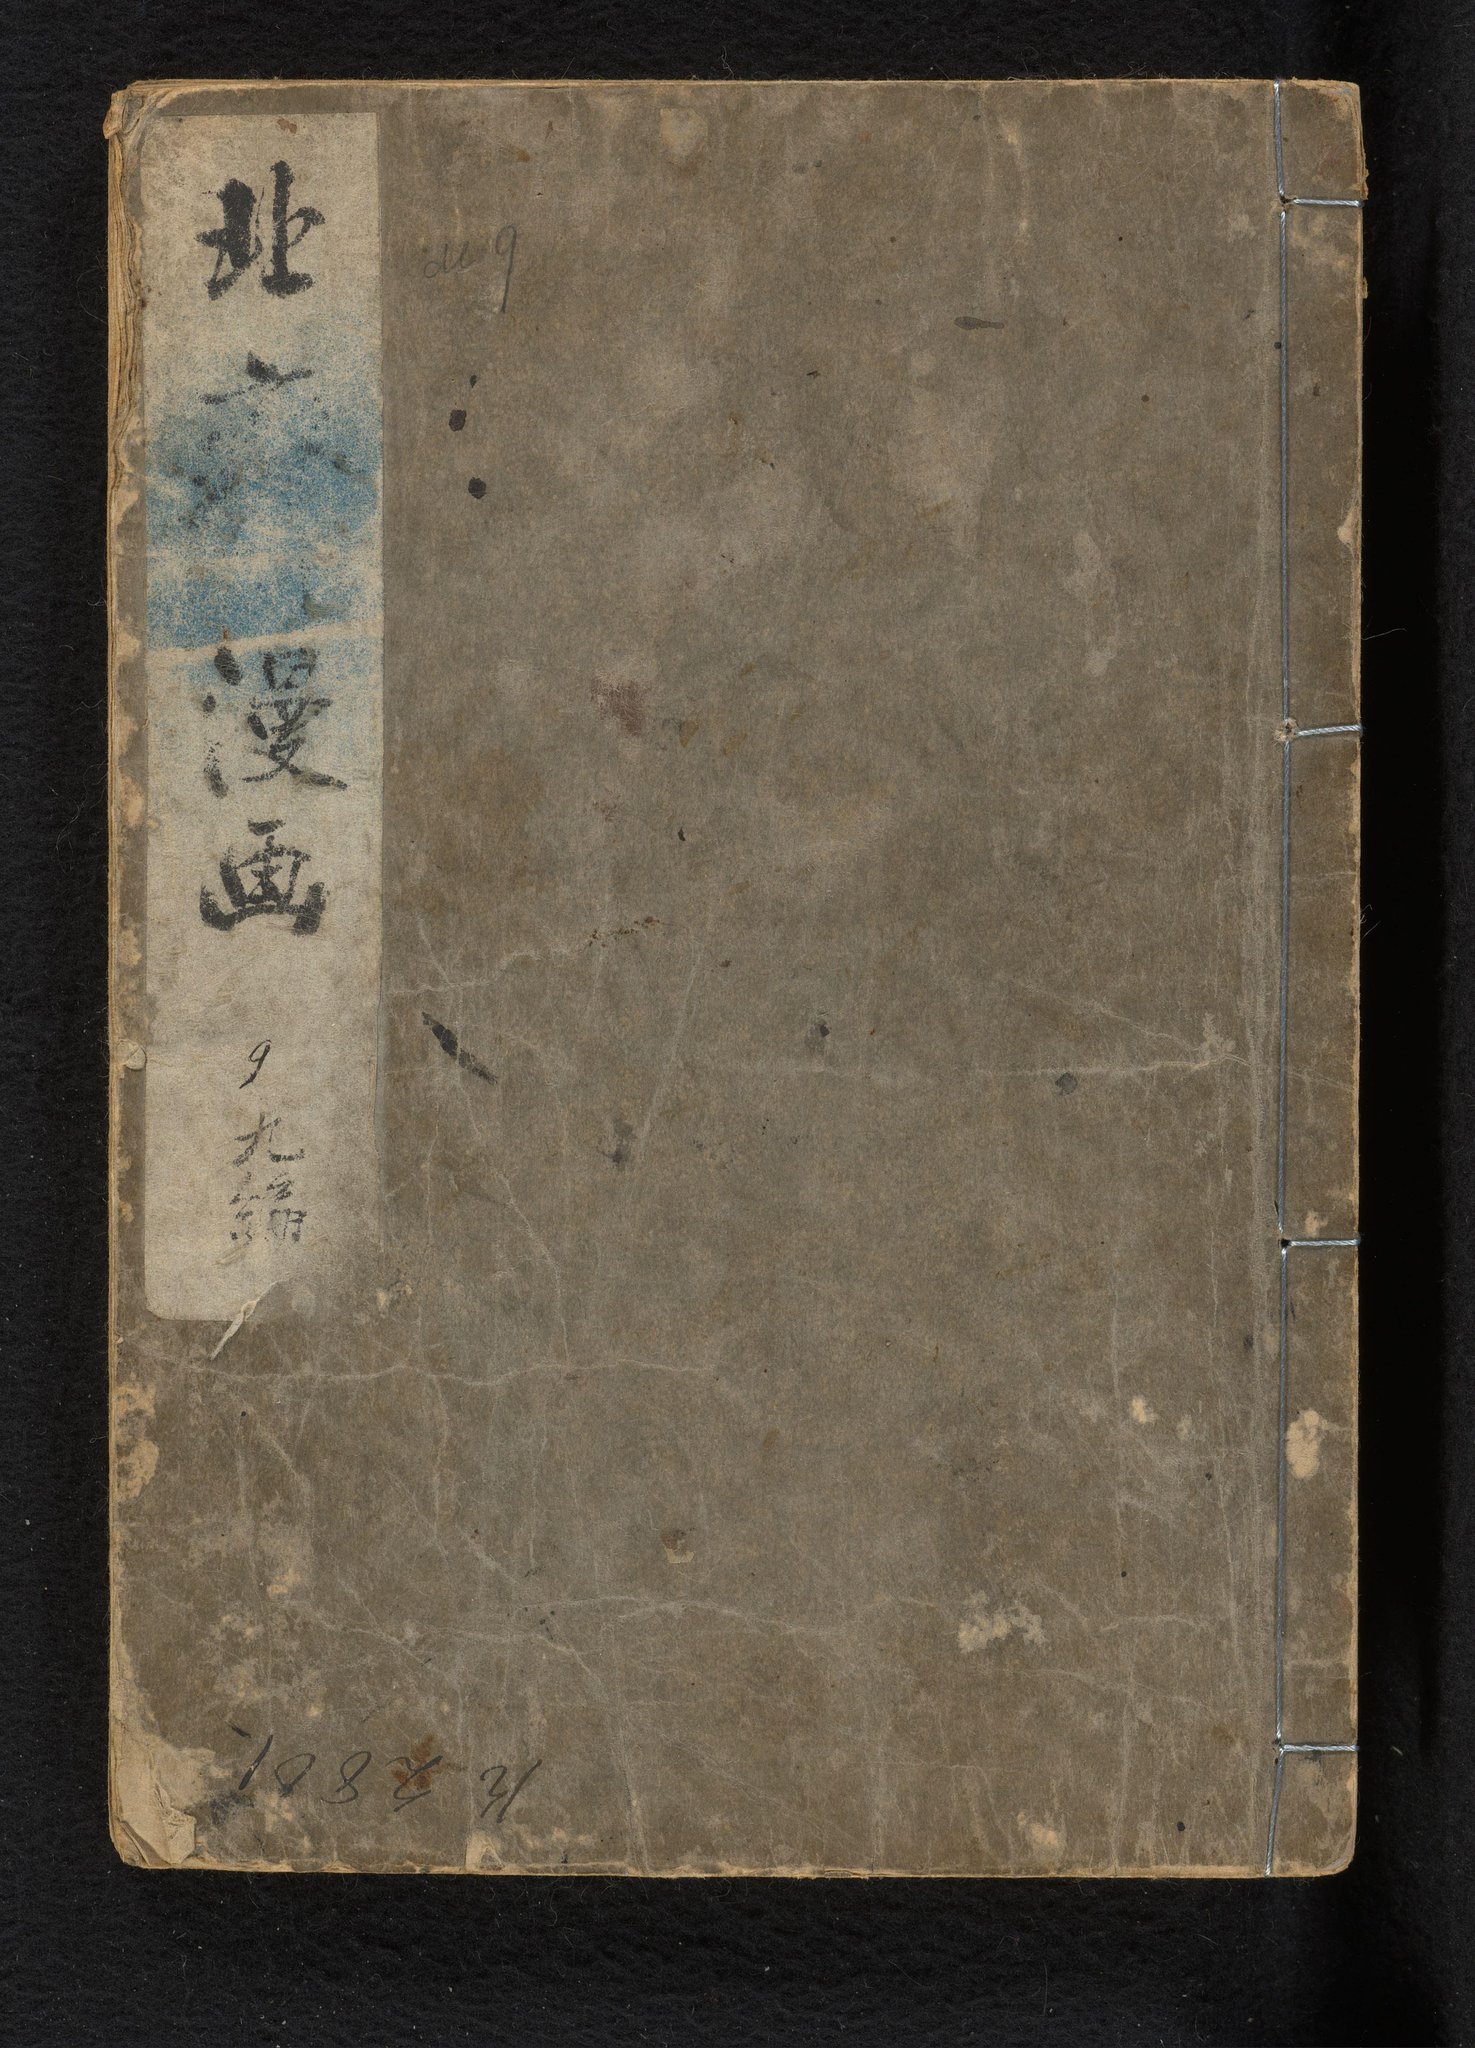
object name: book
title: Schetsen van Hokusai - deel 9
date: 1819-1878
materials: paper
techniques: woodcut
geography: nagoya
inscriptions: inscription, collector's mark: ‘museum van aziatische kunst rijksmuseum Amsterdam-z.’